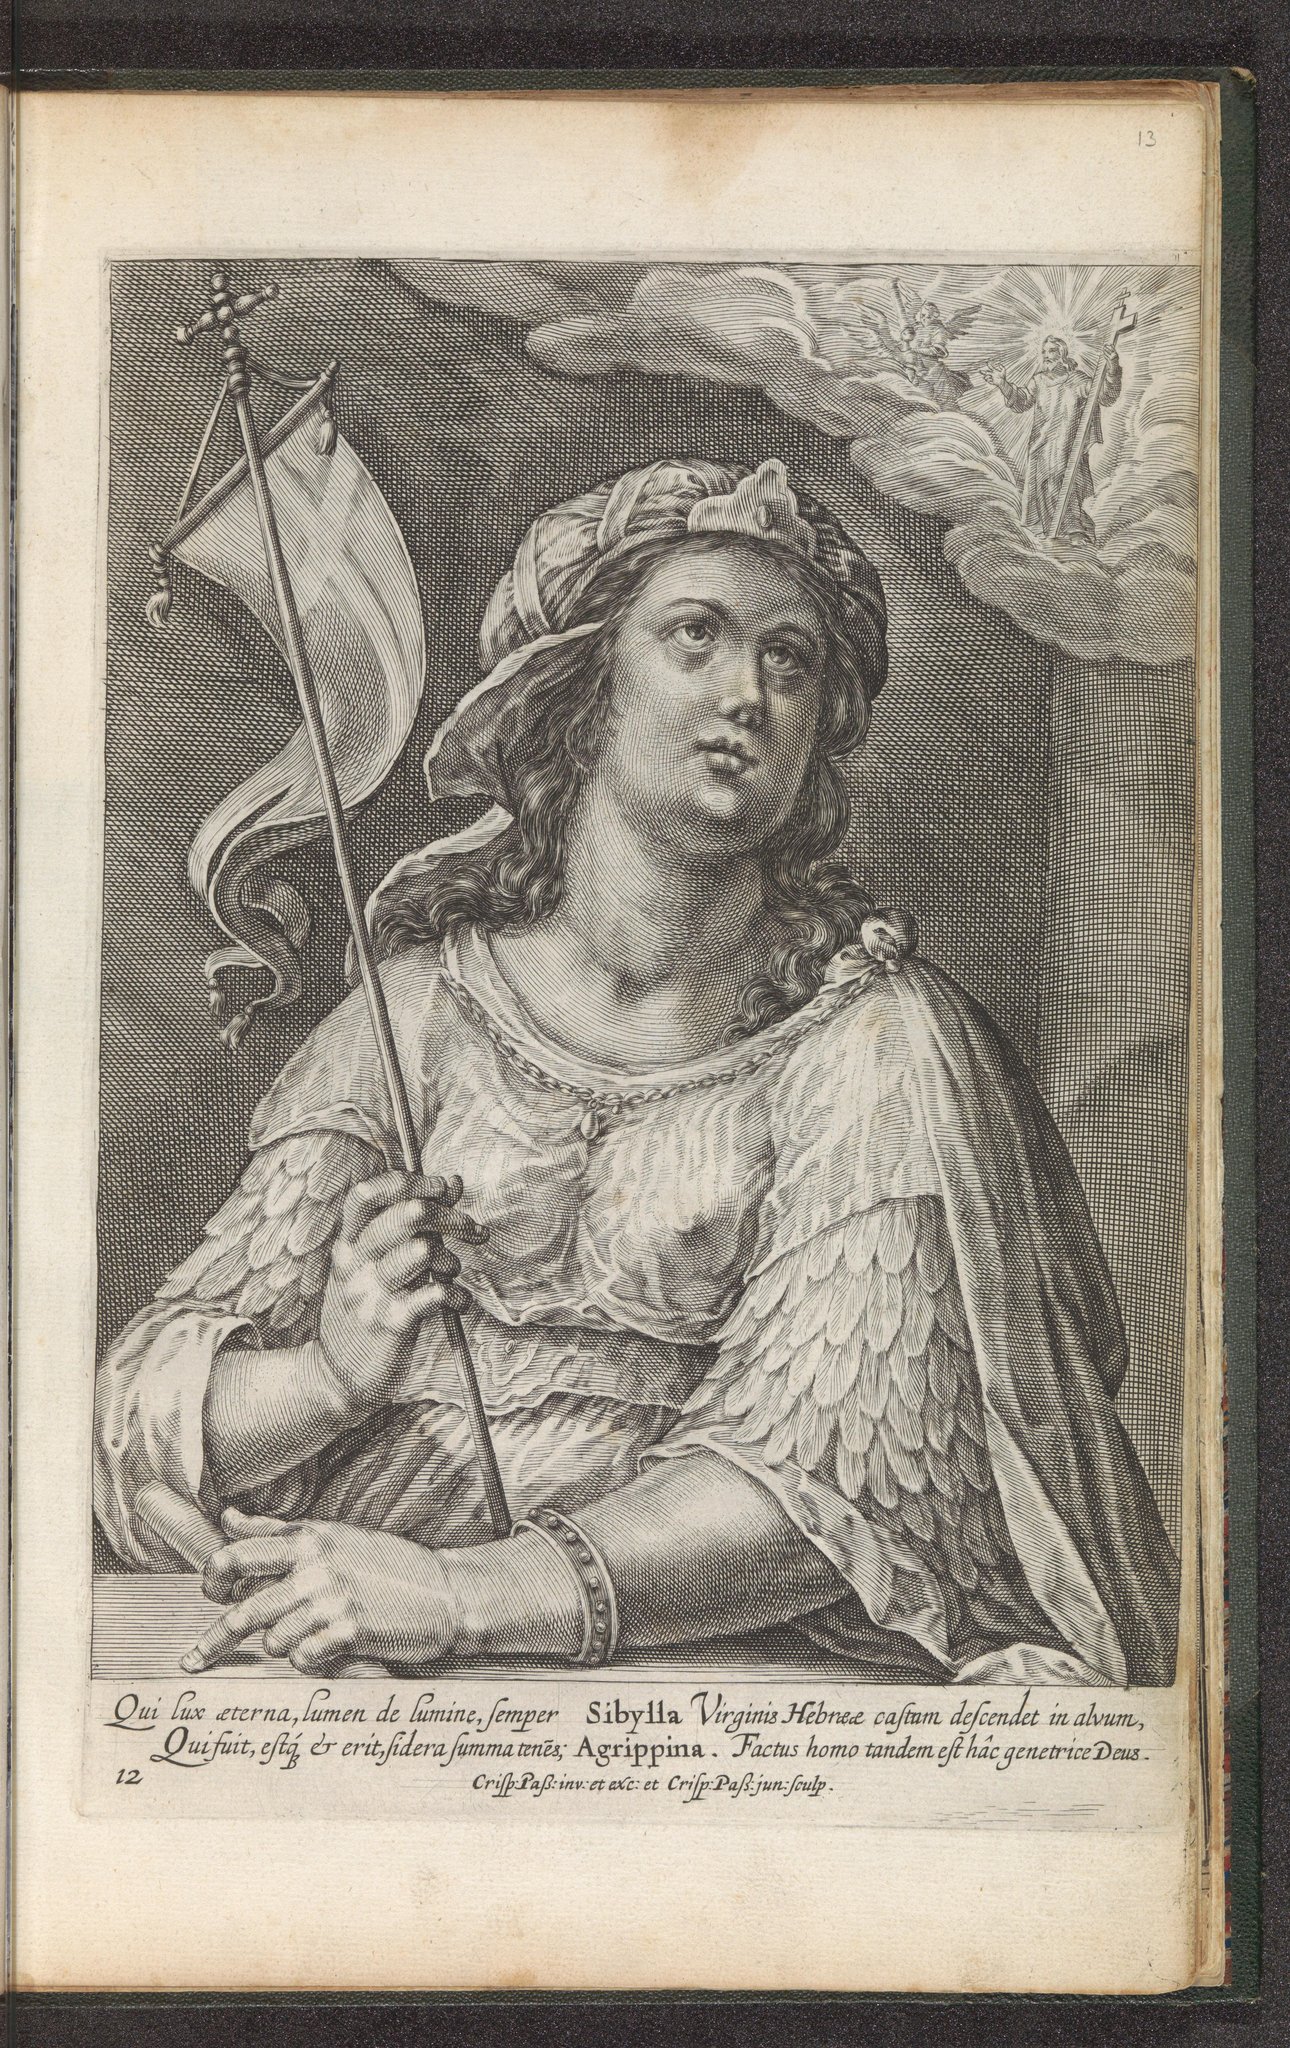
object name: album leaf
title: Sibillen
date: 1615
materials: paper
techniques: engraving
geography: utrecht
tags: types of adult christ (alone), agrippine sibyl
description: De Sibille Agrippina zit met een vaandel in haar rechterhand. Ze kijkt op naar de hemel waar Christus met het kruis en twee engelen verschijnen. Onder de voorstelling een onderschrift in het Latijn. Deze prent maakt deel uit van een album.